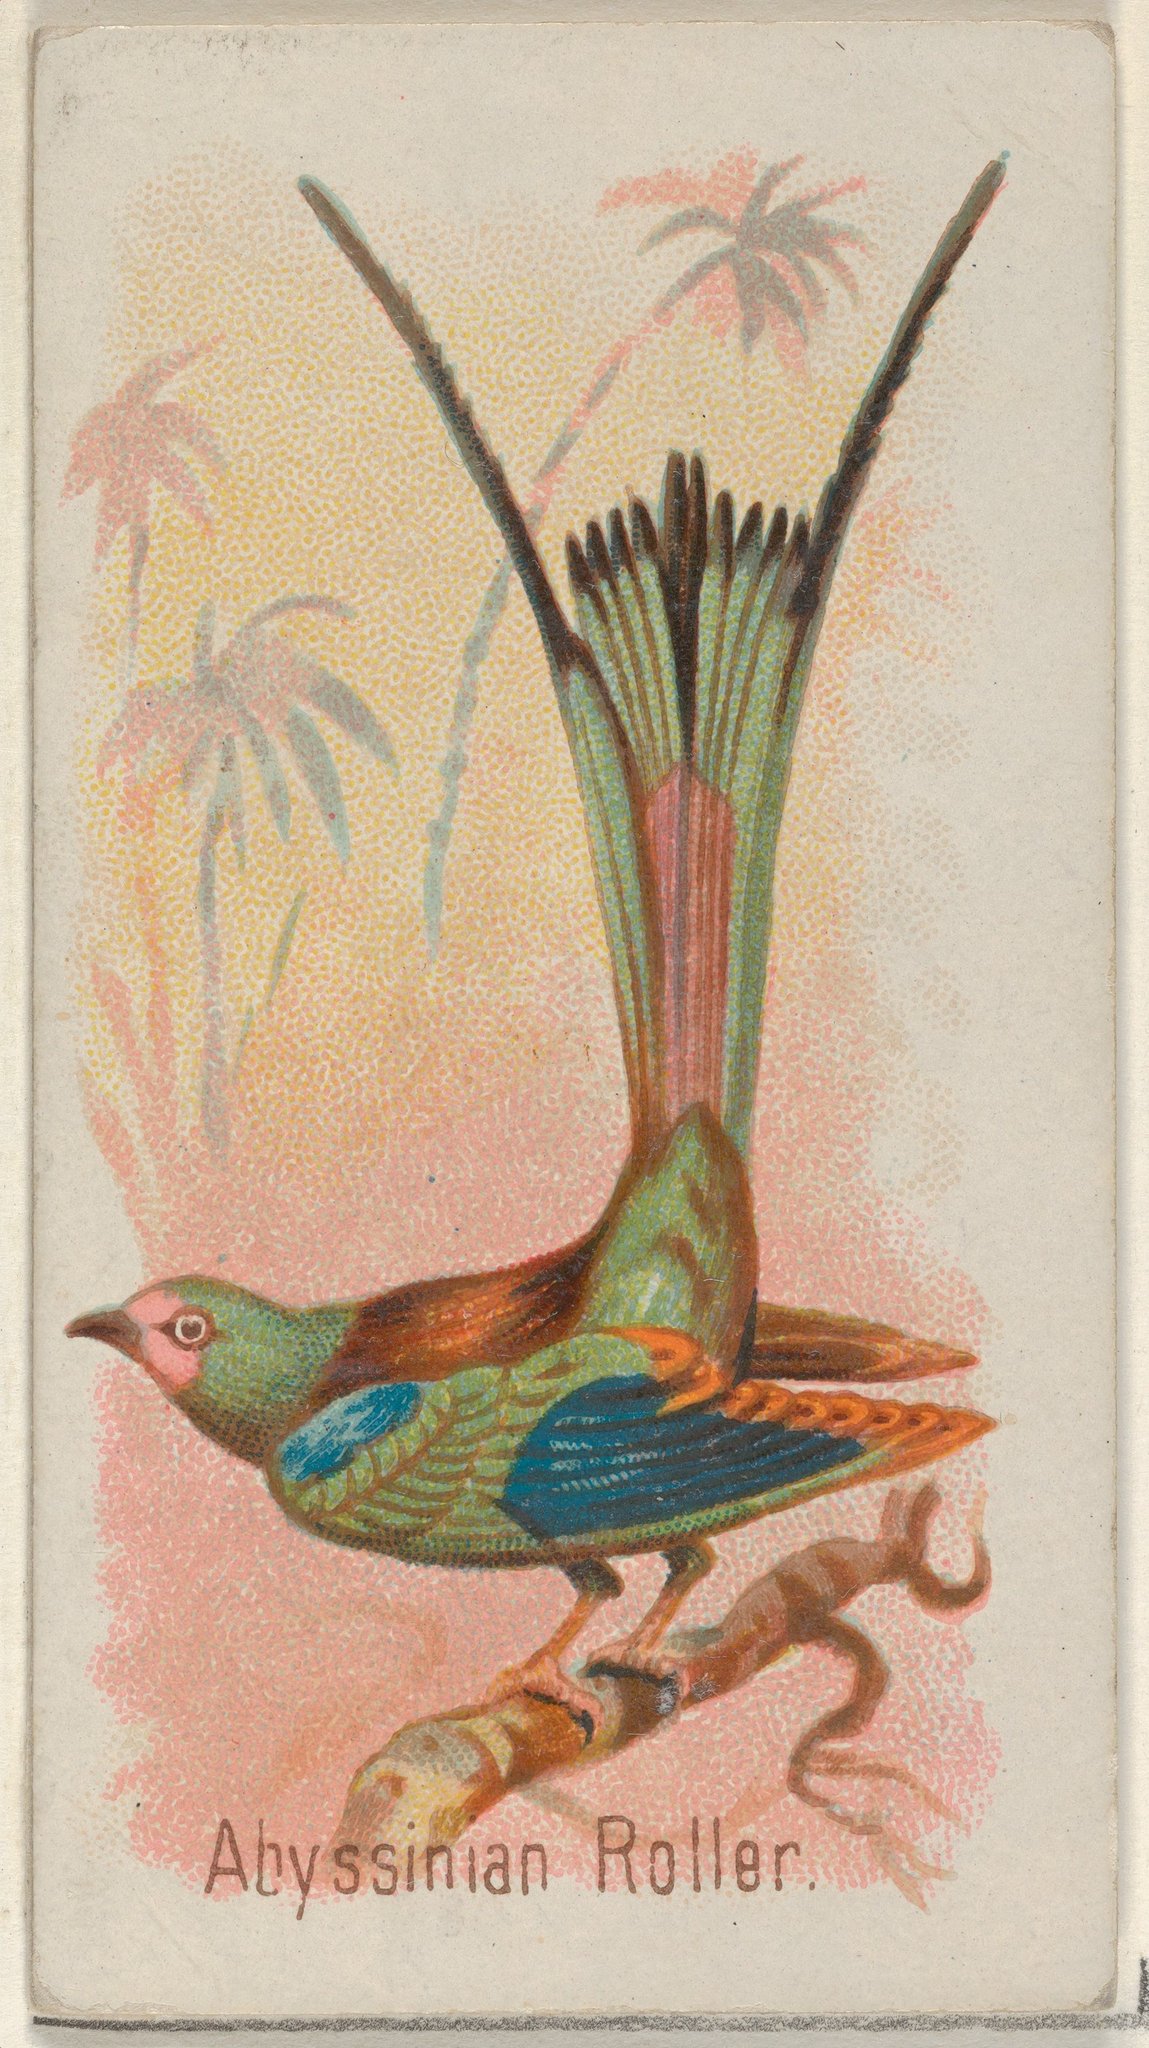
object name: print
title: Abyssinian Roller, from the Song Birds of the World series (N23) for Allen & Ginter Cigarettes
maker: allen & ginter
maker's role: publisher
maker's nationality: american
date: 1890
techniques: color lithograph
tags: birds